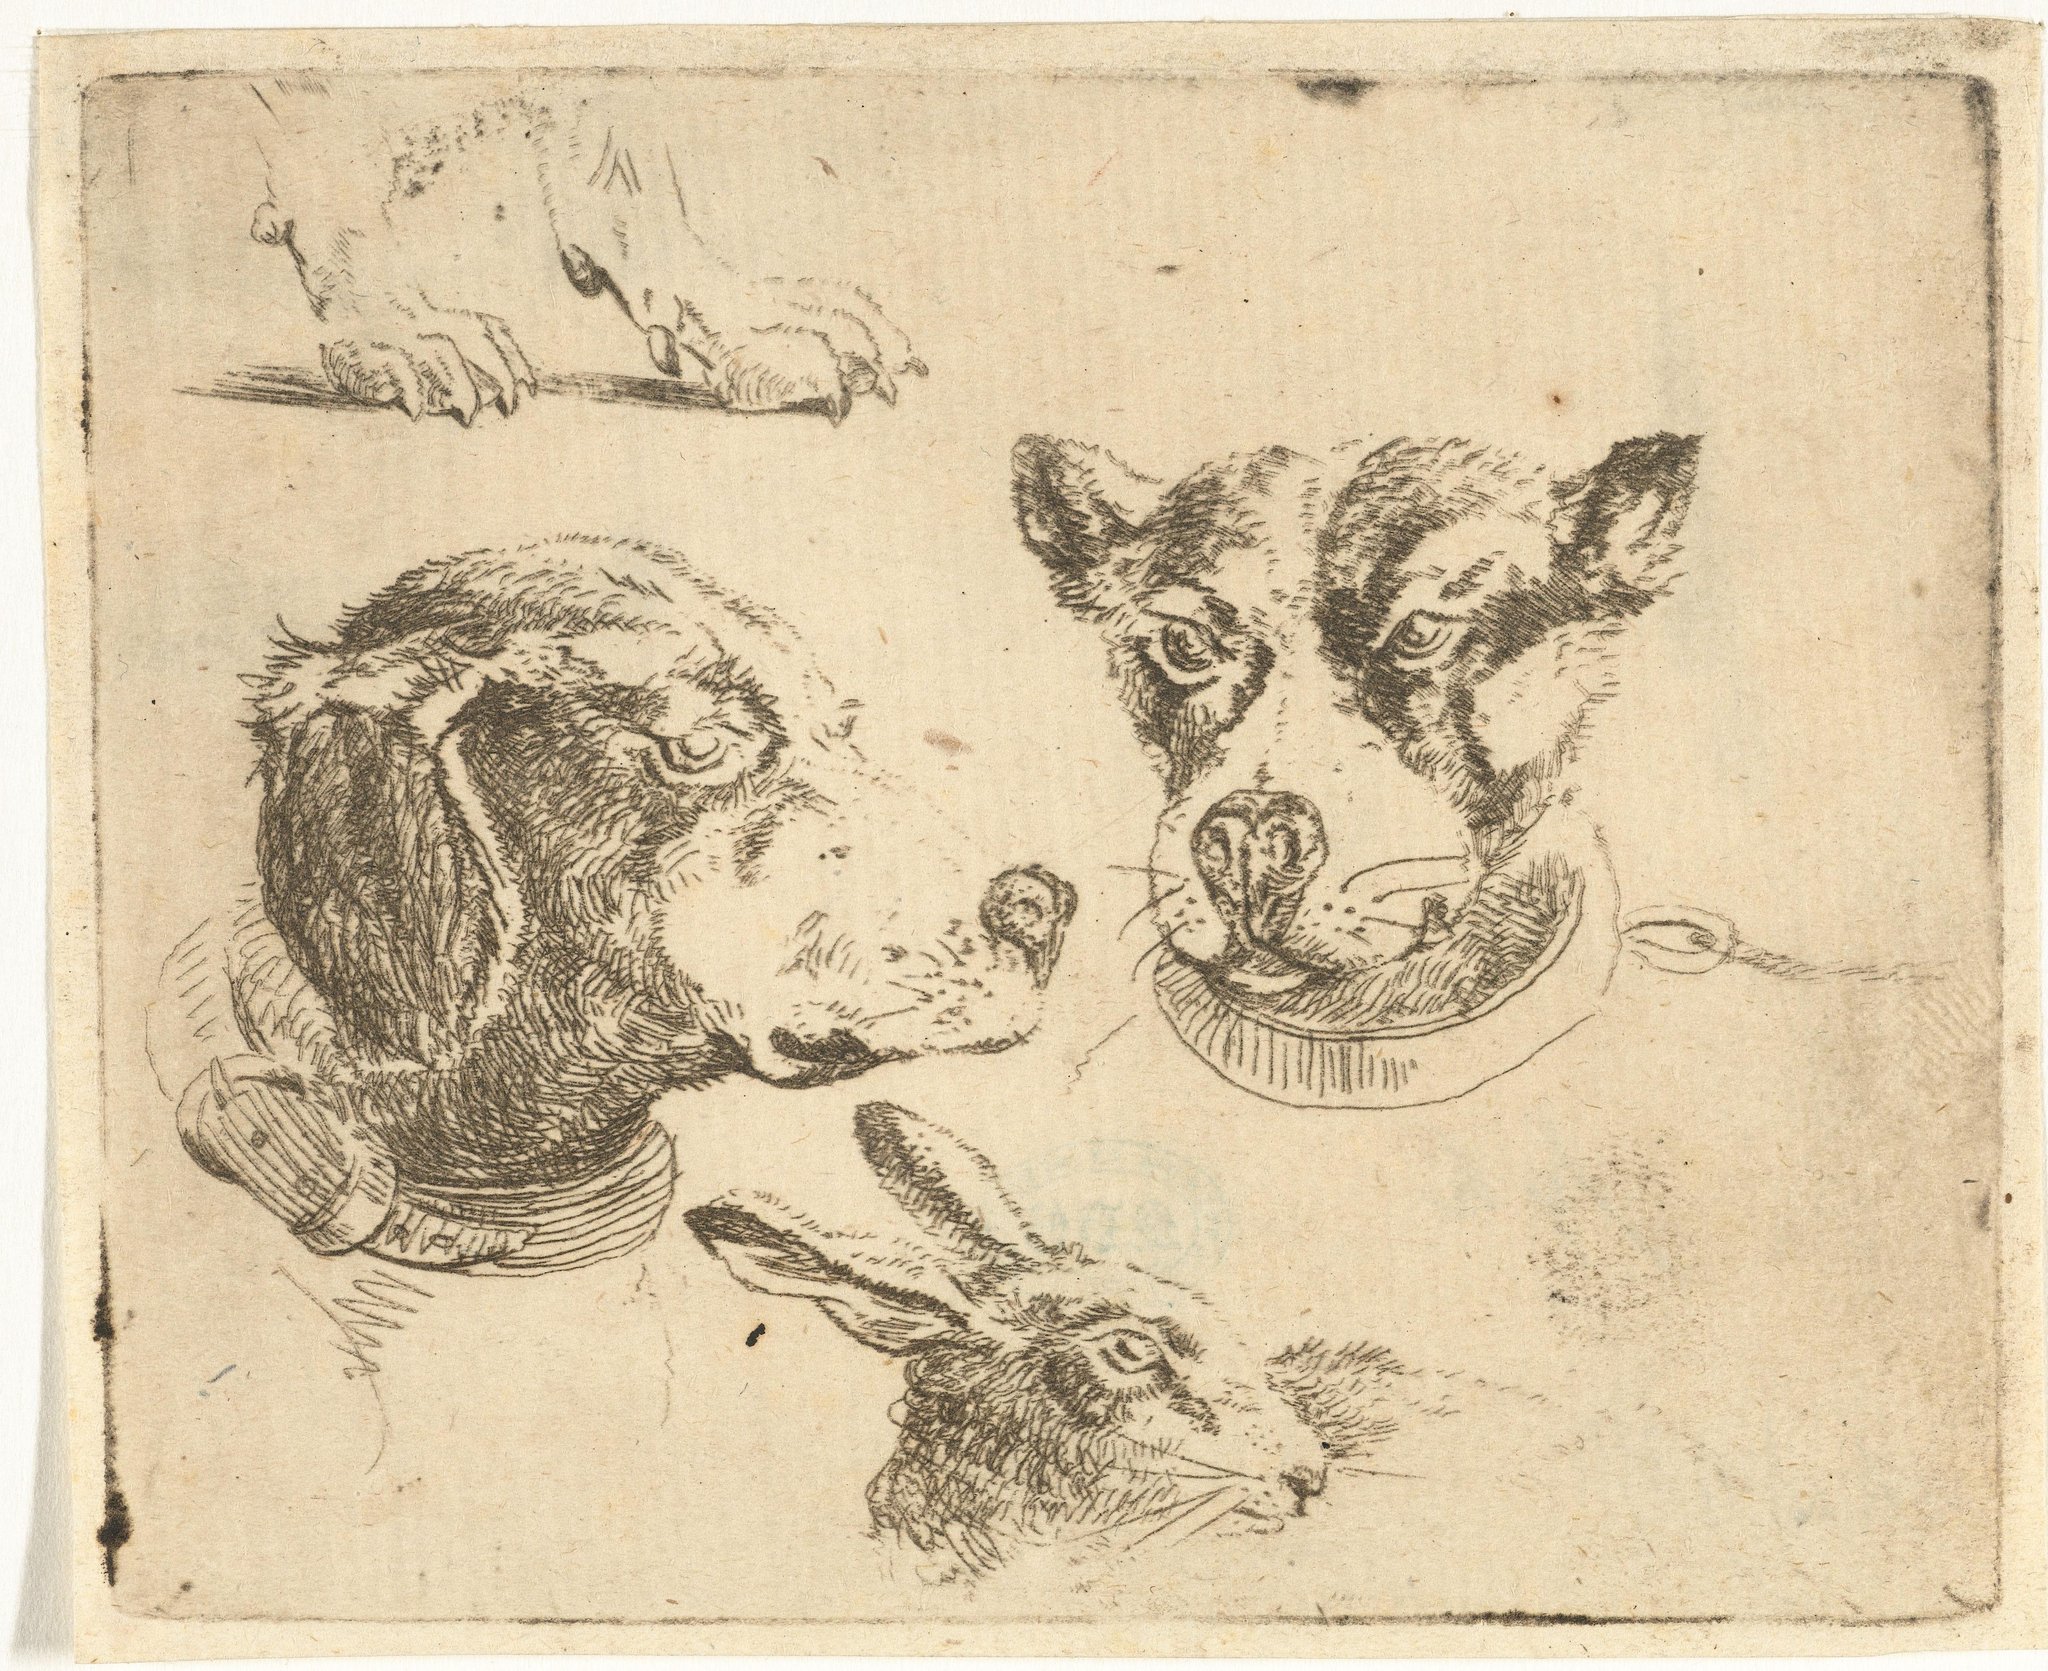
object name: print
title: Studieblad met twee hondenkoppen, poten van hond en kop van haas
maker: jan dasveldt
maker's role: draughtsman, print maker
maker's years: 1770-1855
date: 1780-1855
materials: paper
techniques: etching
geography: amsterdam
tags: rodents: hare, dog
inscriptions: collector's mark: Lugt 1962, collector's mark: Lugt 2228